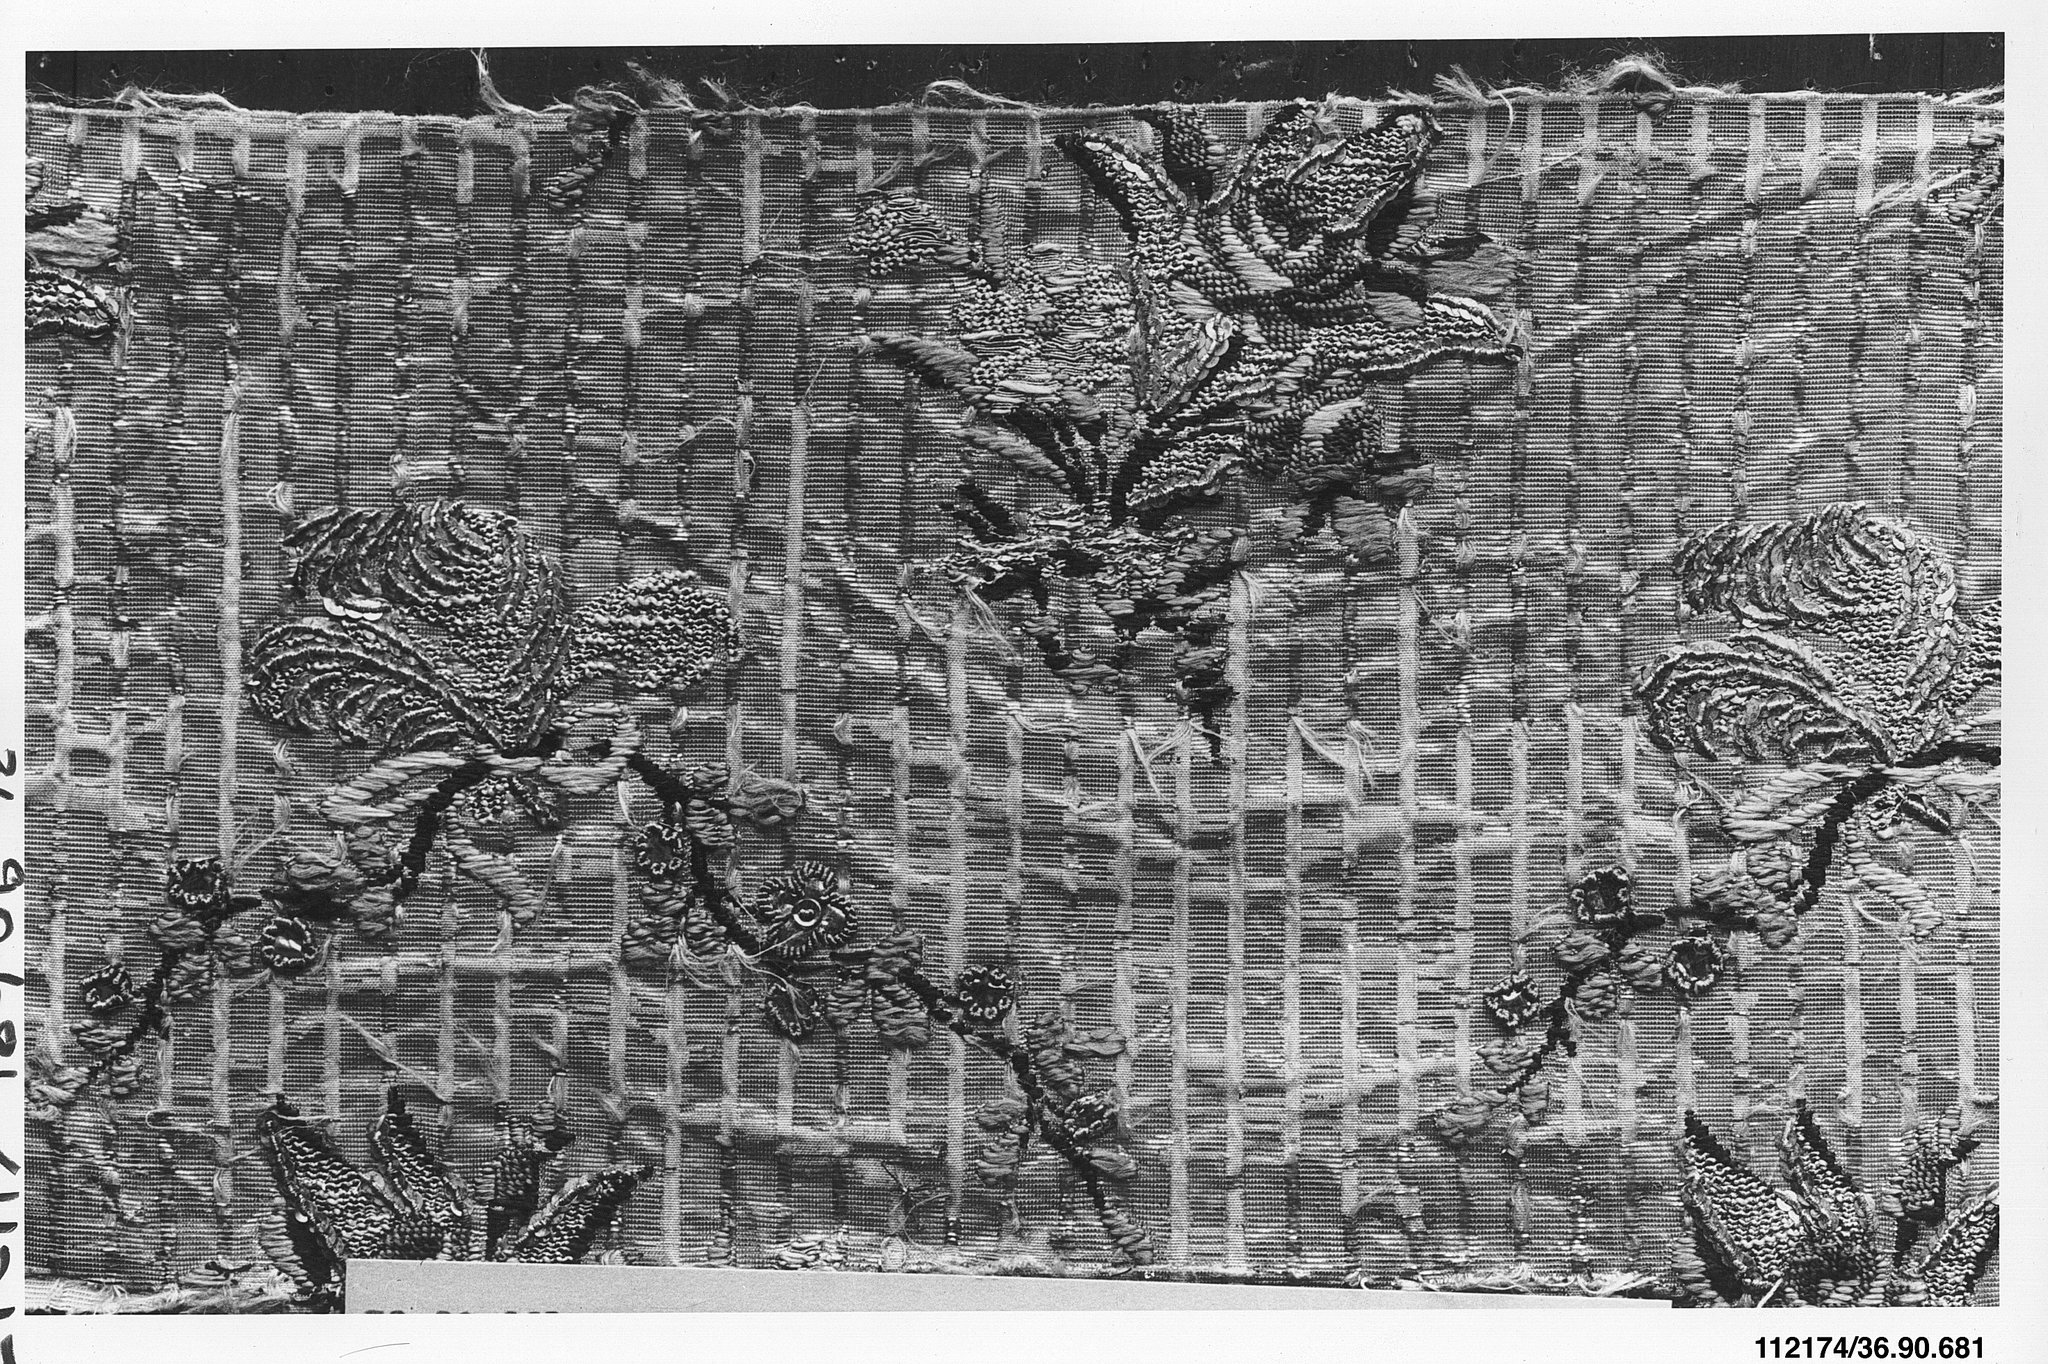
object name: piece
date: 1760-1770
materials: metal thread, silk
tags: leaves